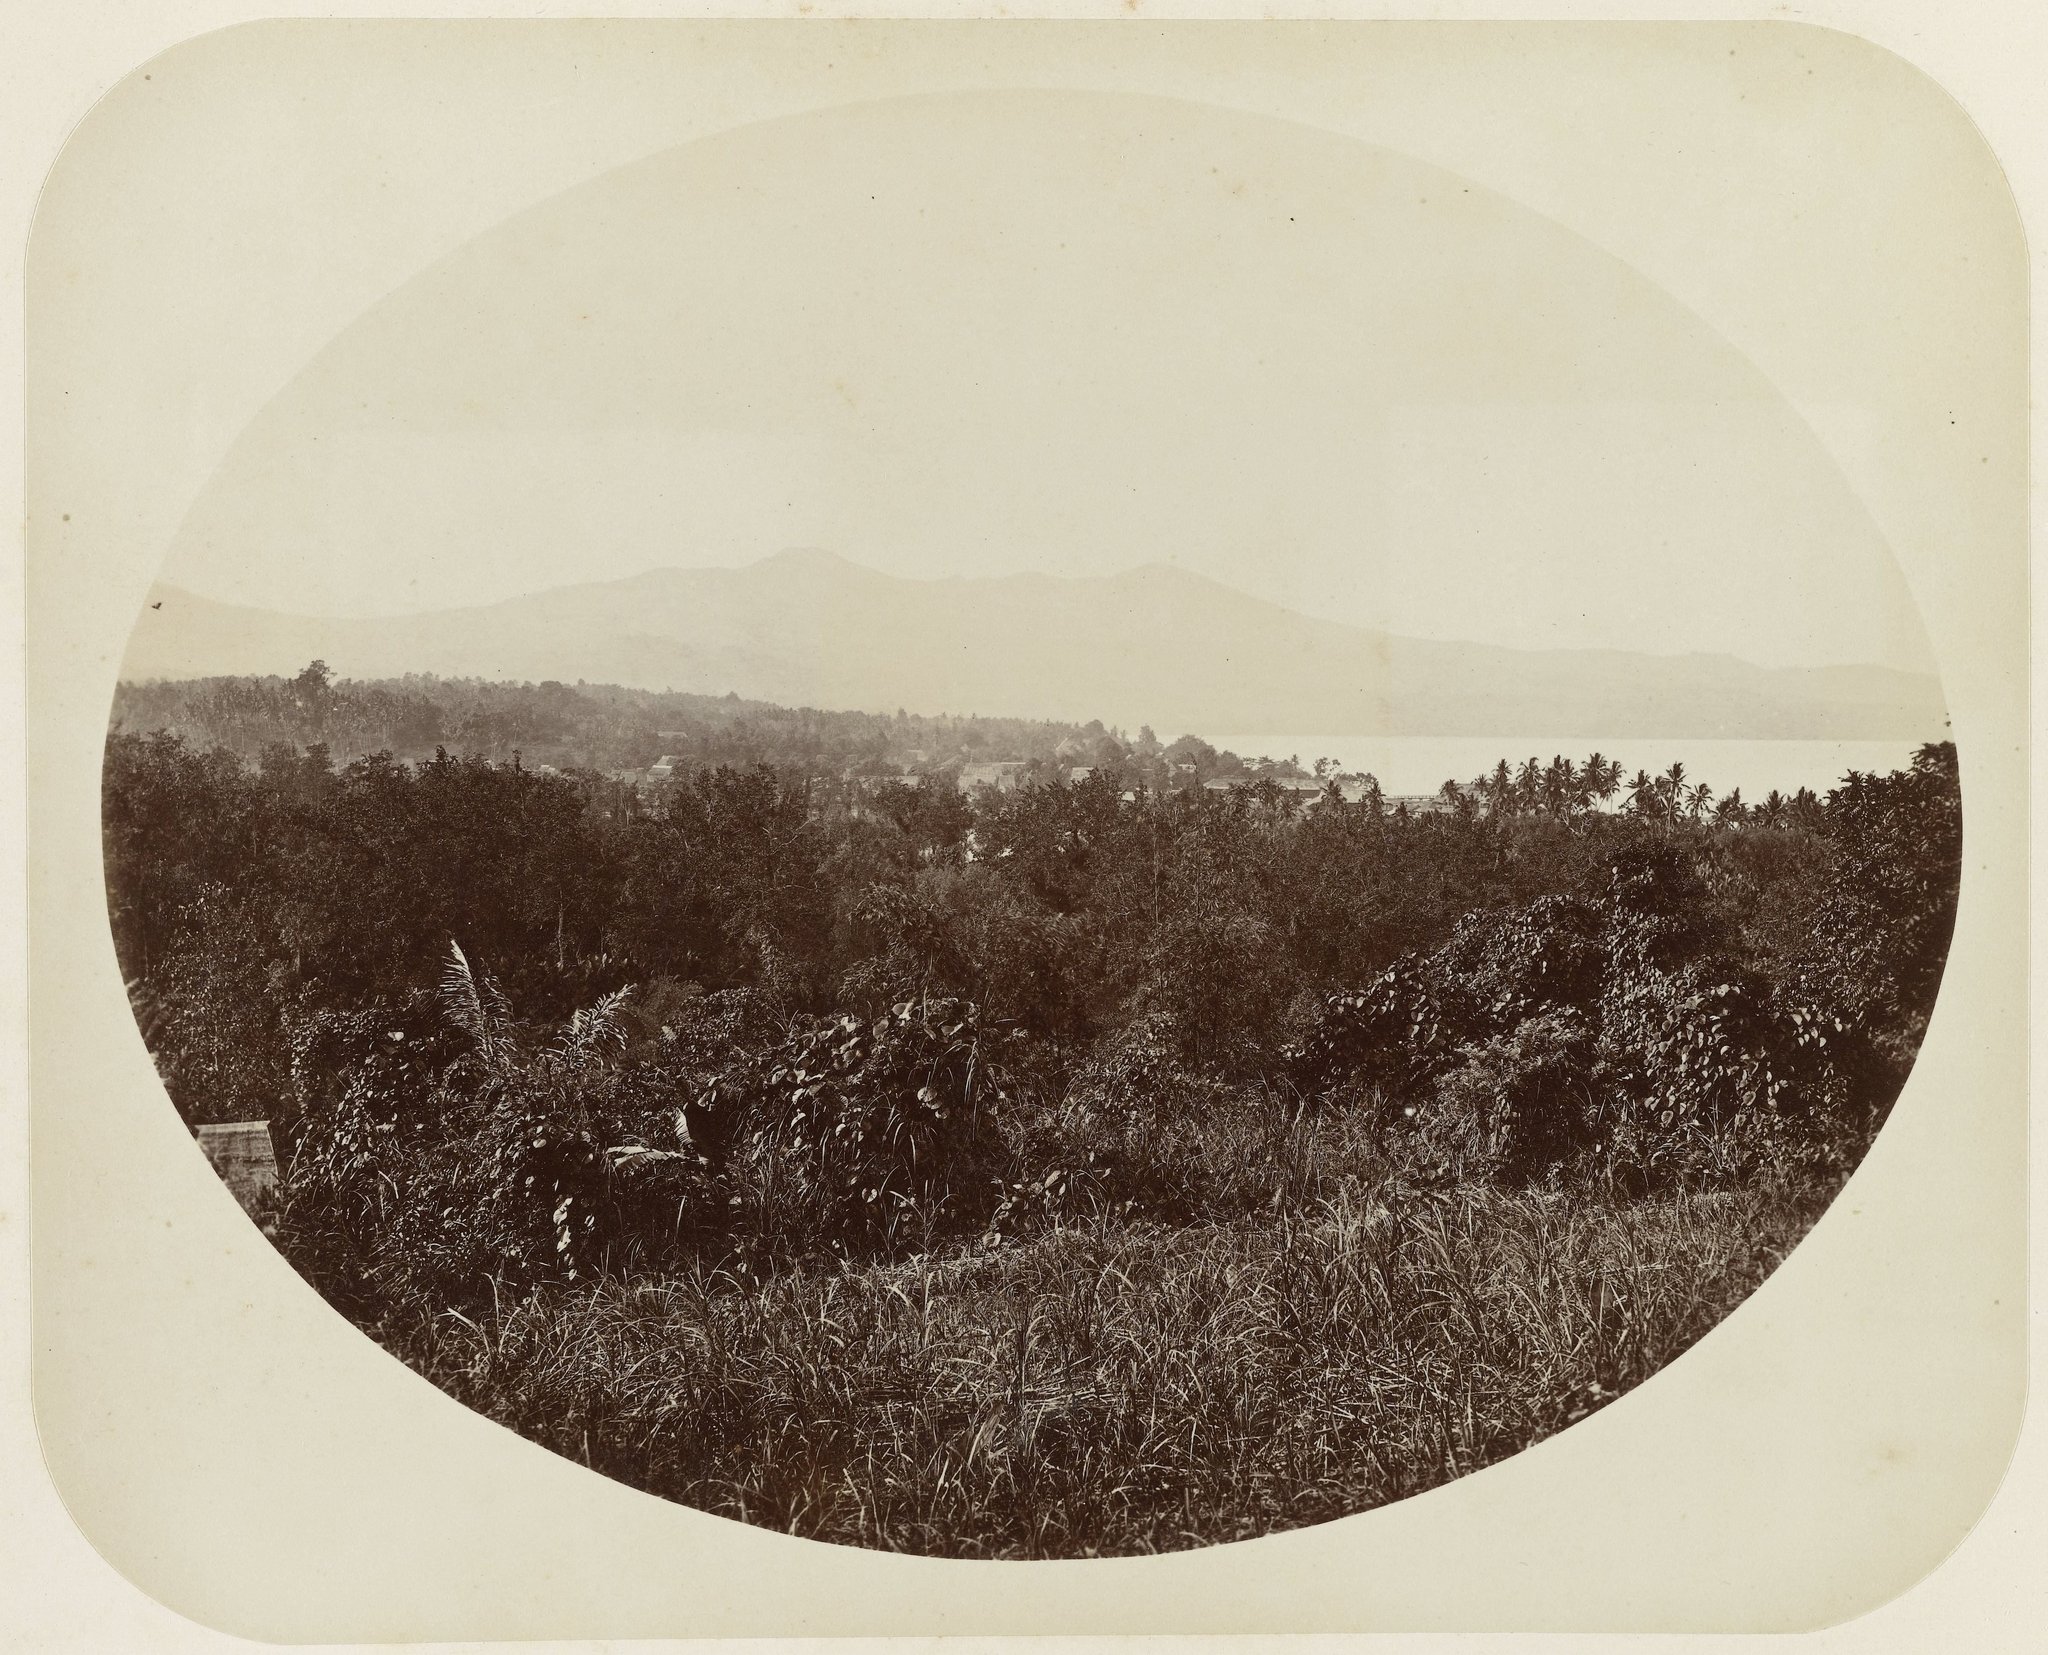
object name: photograph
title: Baai van Manado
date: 1870-1890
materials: photographic support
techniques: albumen print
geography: celebes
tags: gulf, bay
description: Gezicht op de Baai van Manado (Baai van Menado, Teluk Manado), in het noorden van Celebes. Op de achtergrond de vulkanen Lokon en Empung. Ingeplakte foto in het fotoalbum getiteld: Gezichten van Java.